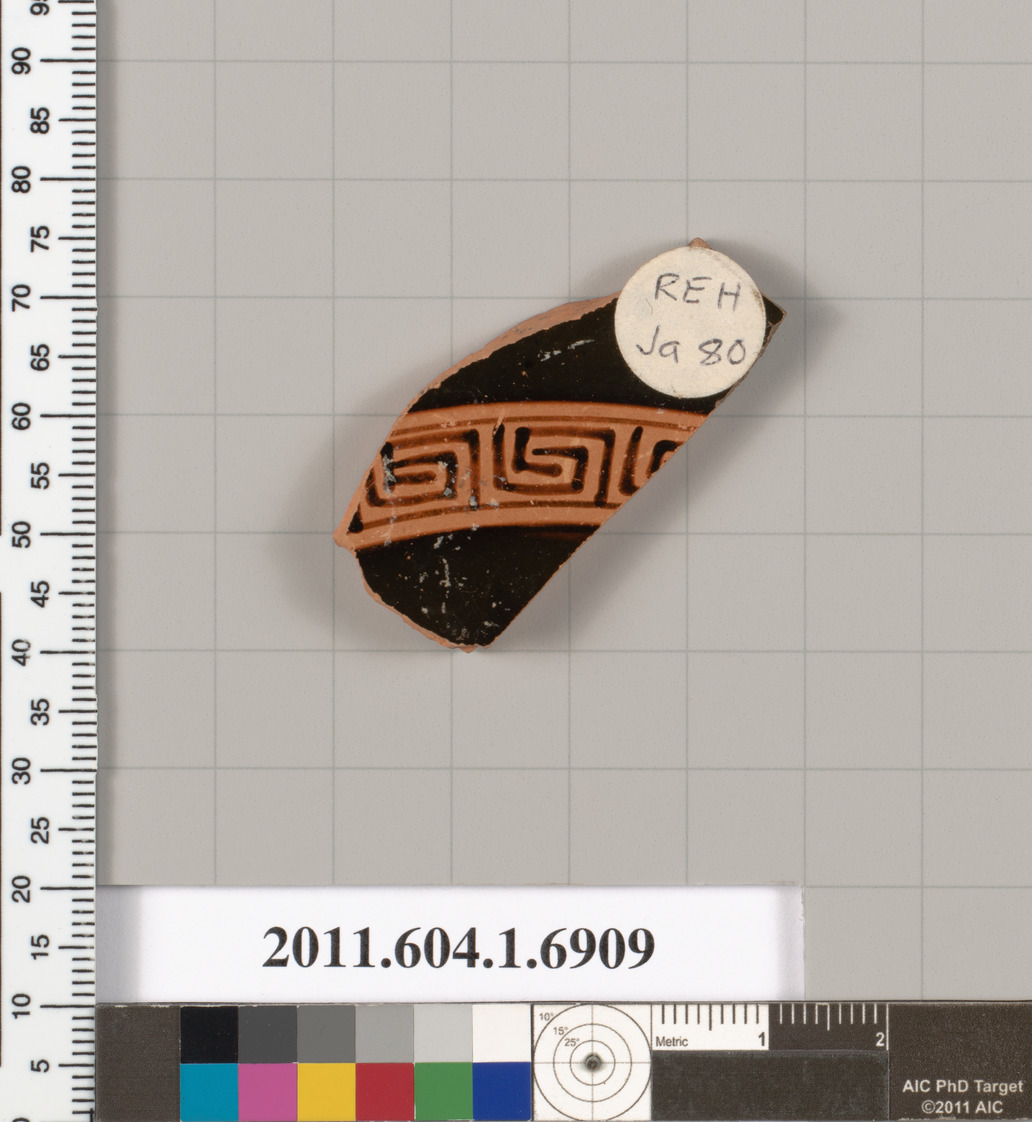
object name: kylix fragment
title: Terracotta fragment of a kylix (drinking cup)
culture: greek, attic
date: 490-470 BCE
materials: terracotta